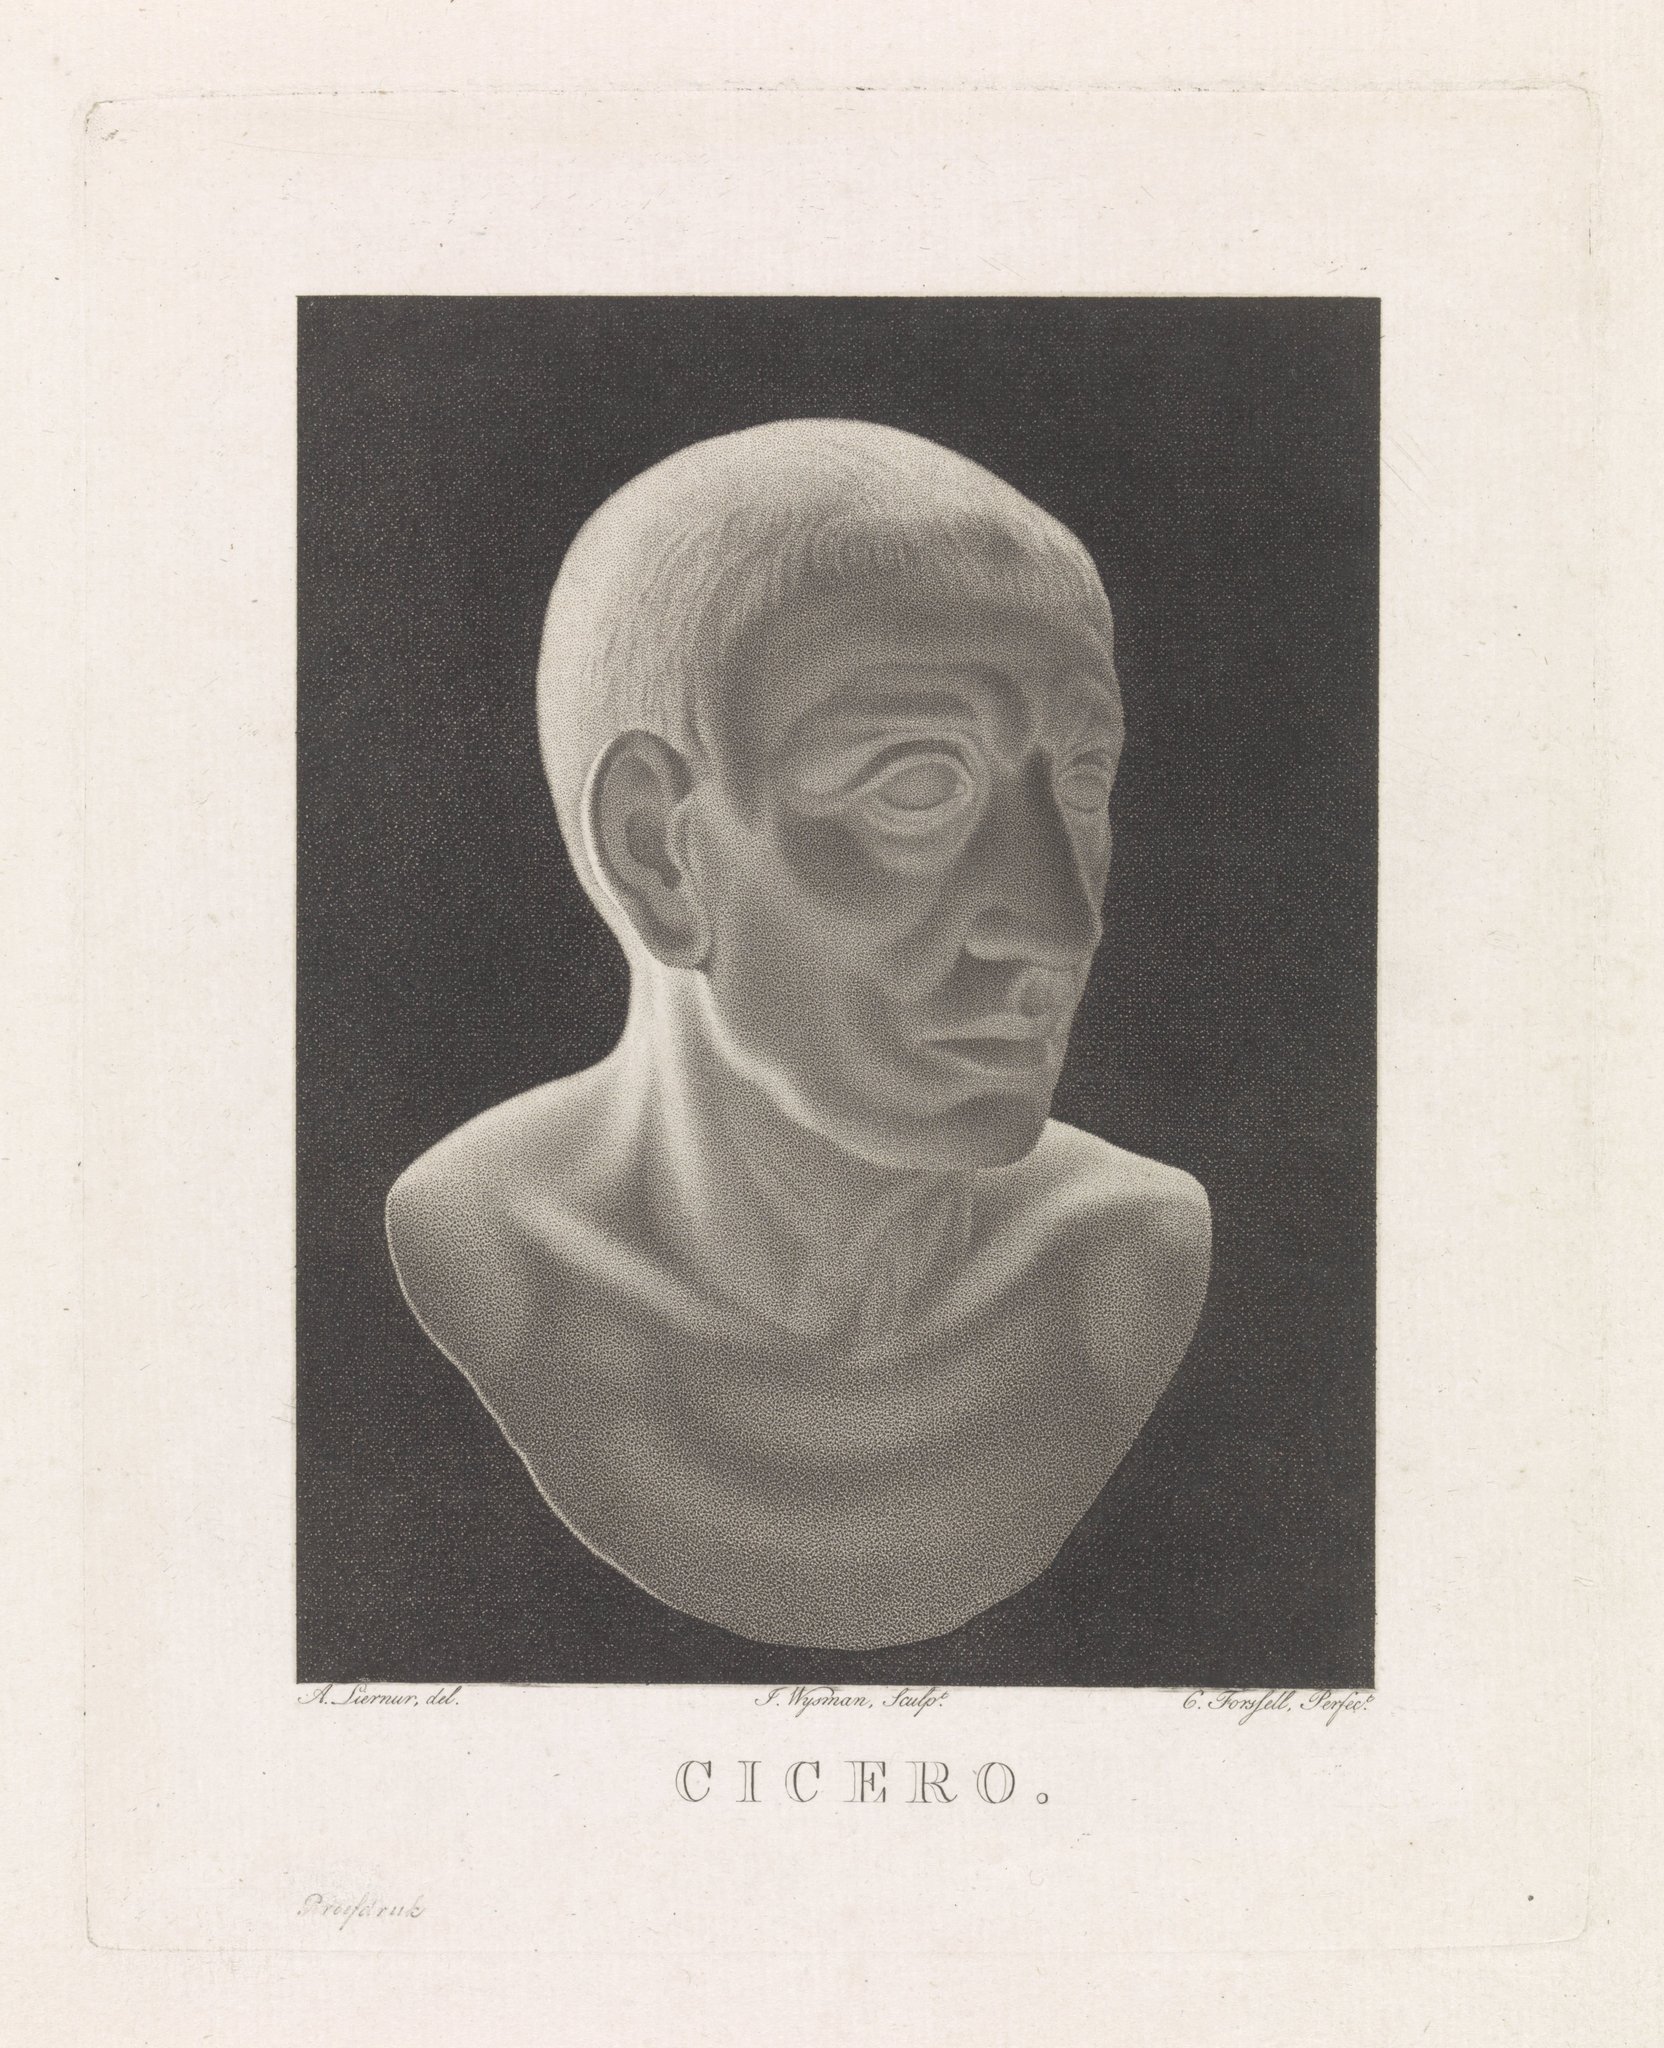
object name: print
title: Borstbeeld van Cicero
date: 1778-1827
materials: paper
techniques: etching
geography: amsterdam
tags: marcus tullius cicero, piece of sculpture, reproduction of a piece of sculpture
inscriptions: collector's mark: Lugt 2228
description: Borstbeeld van Cicero. Naar een beeldhouwwerk.